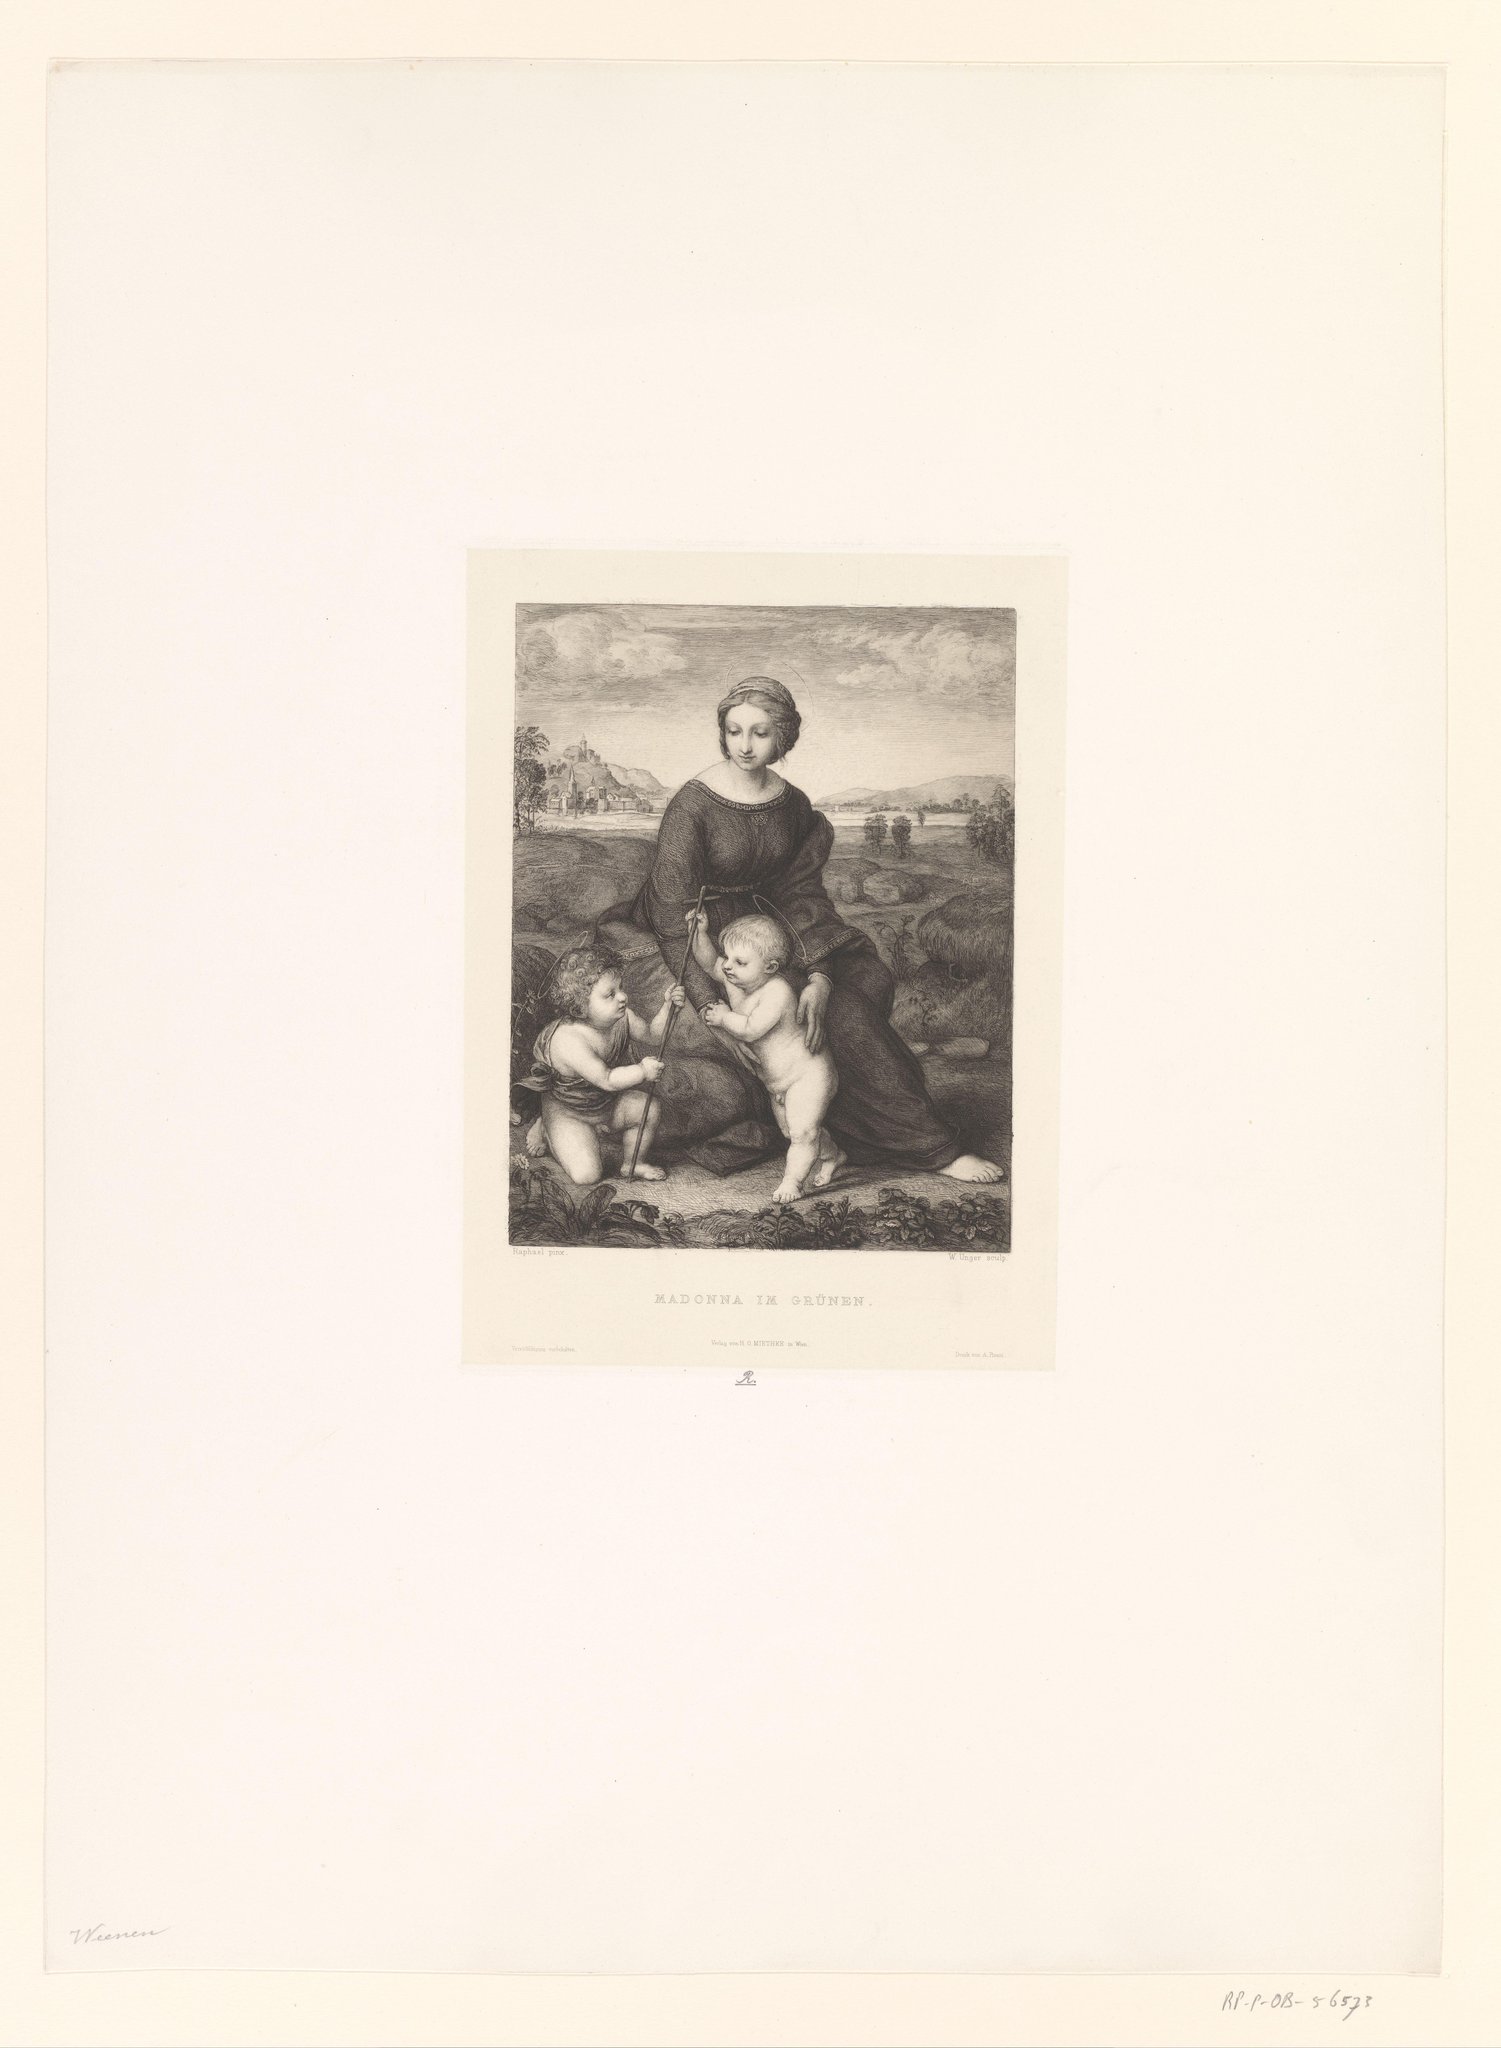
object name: print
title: Maria met kind en Johannes de Doper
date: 1861-1889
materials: paper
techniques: etching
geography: vienna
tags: john the baptist; possible attributes: book, reed cross, baptismal cup, honeycomb, lamb, staff - early life of male saint, mary (standing) with the christ-child in front of her (free-standing or leaning against her)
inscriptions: collector's mark: Lugt 2228